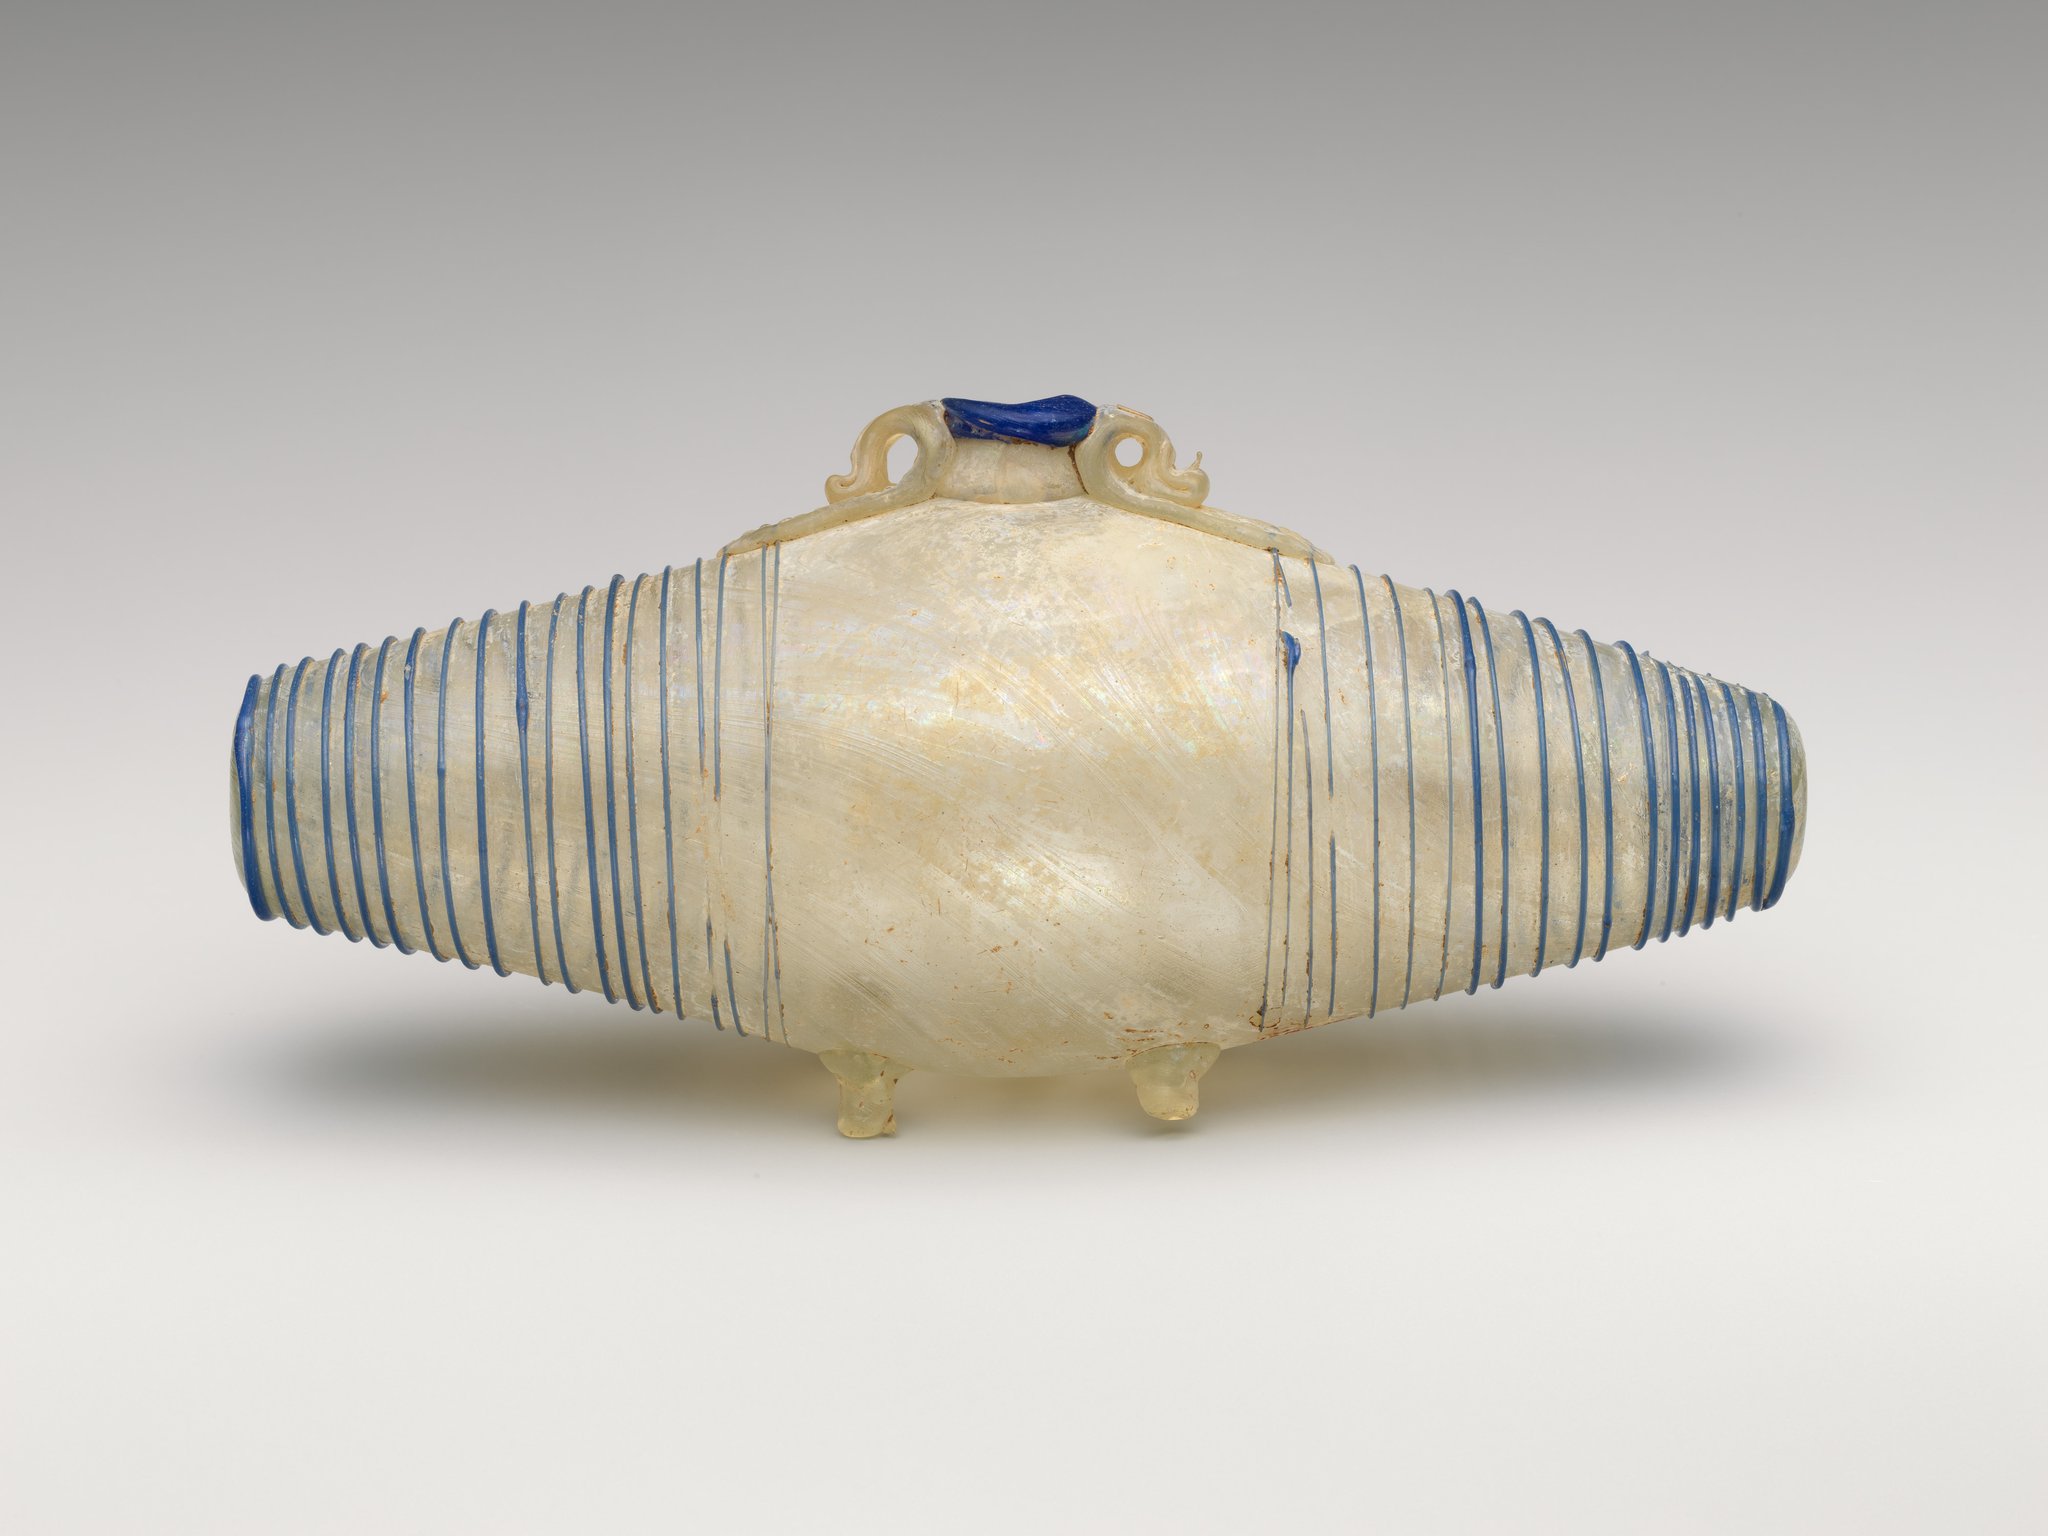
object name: flask, barrel shaped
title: Glass barrel-shaped flask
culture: roman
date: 167-233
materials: glass